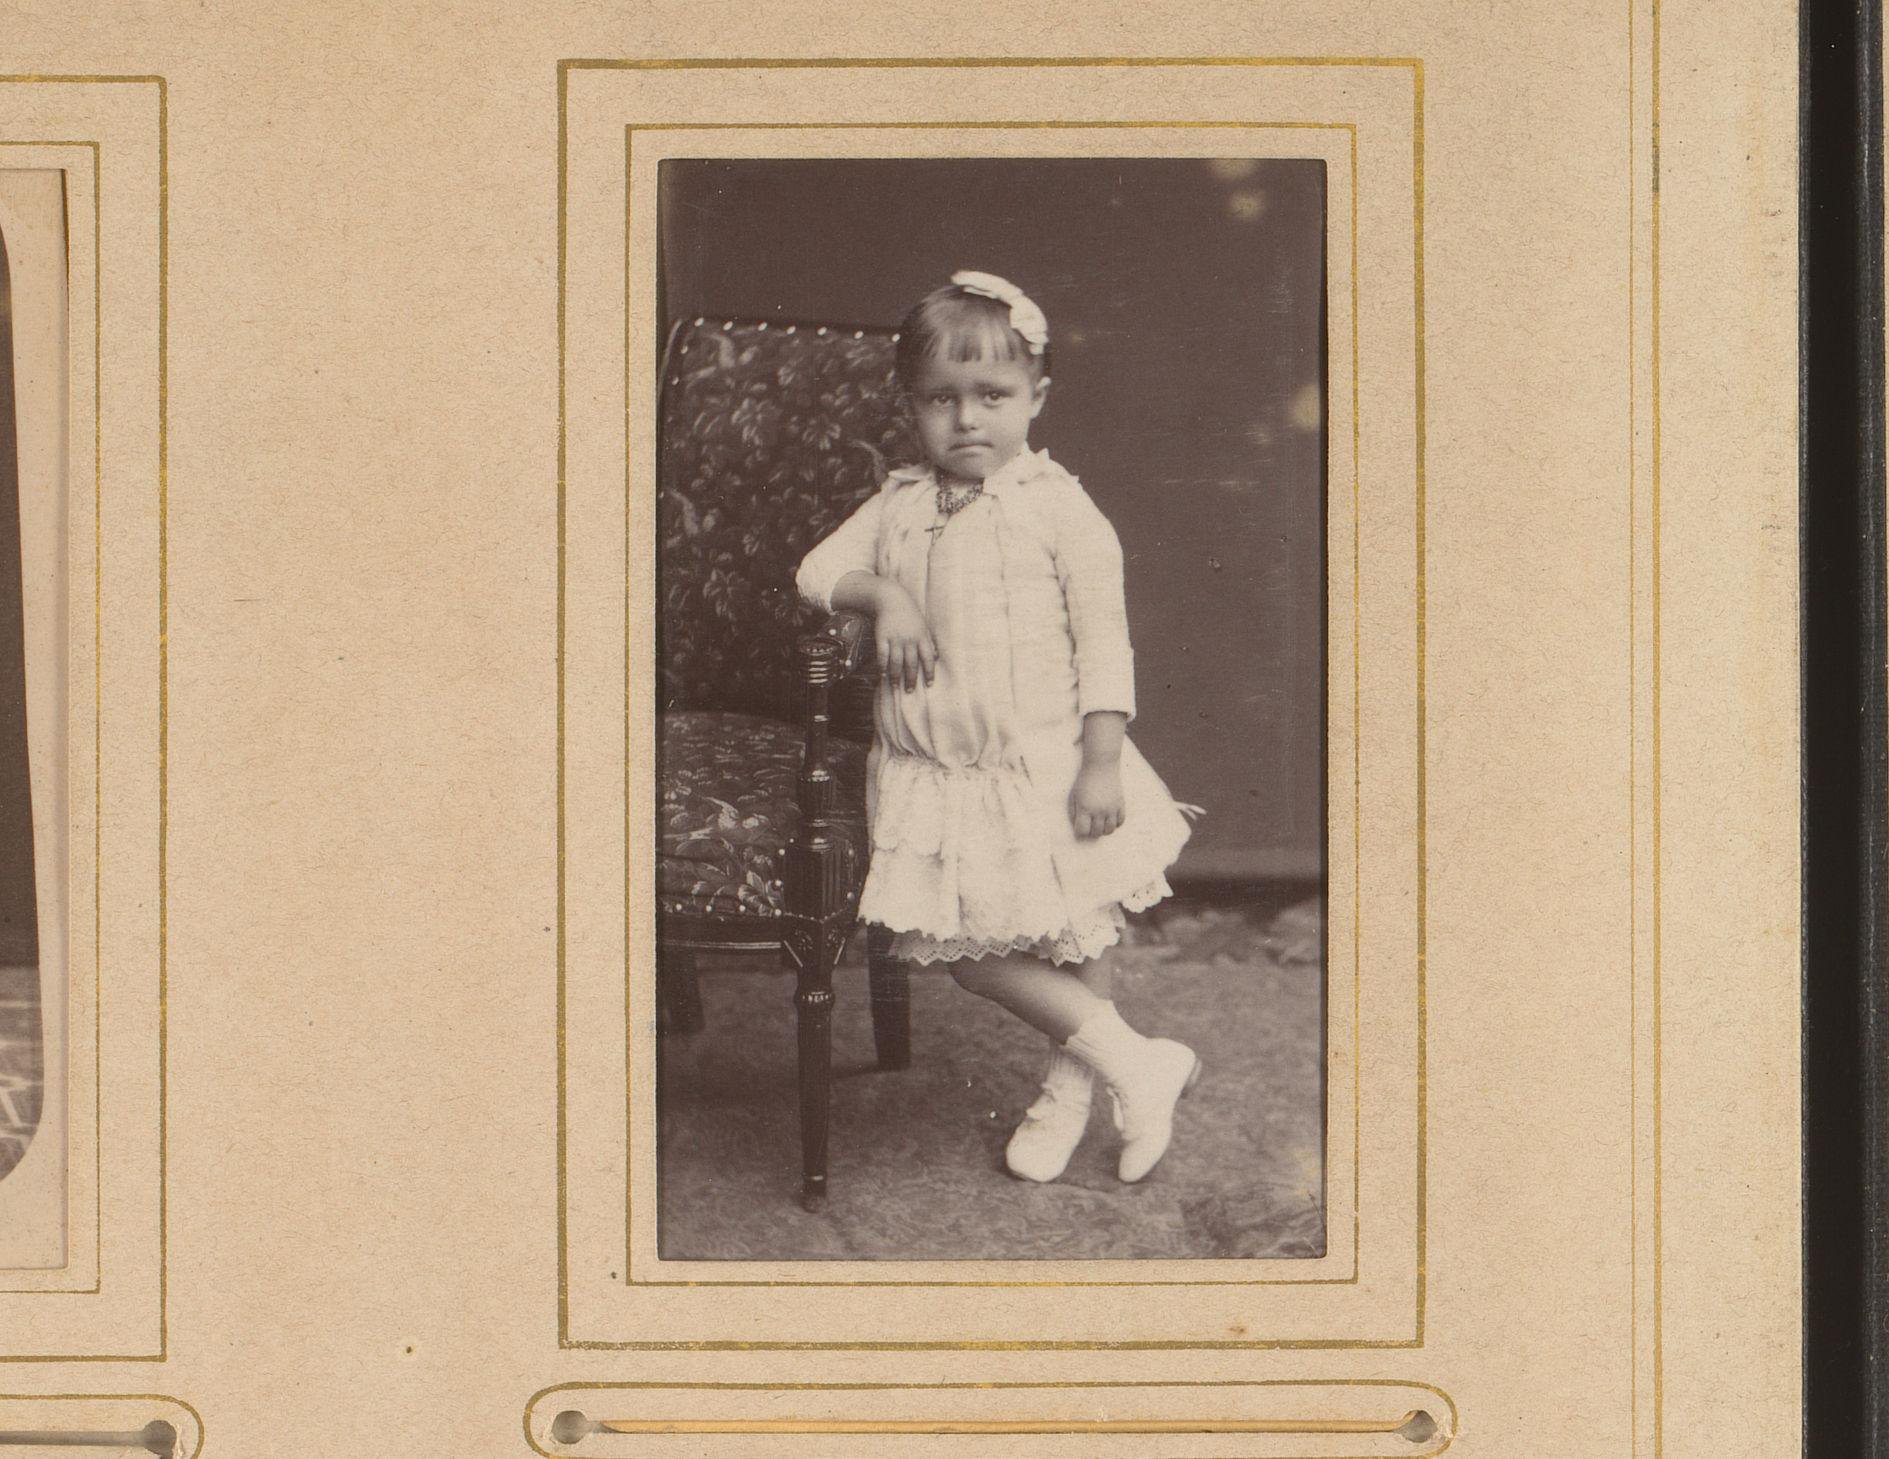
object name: album leaf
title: Portret van een meisje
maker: auguste despret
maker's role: fotograaf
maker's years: 1827-1897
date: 1880-1891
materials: cardboard, photographic support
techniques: albumen print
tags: historical persons, girl (child between toddler and youth)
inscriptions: inscription: ‘Brevets d'invention/ Medailles, récompenses et diplomes d'honneur aux expositions Photographie/ (...)’